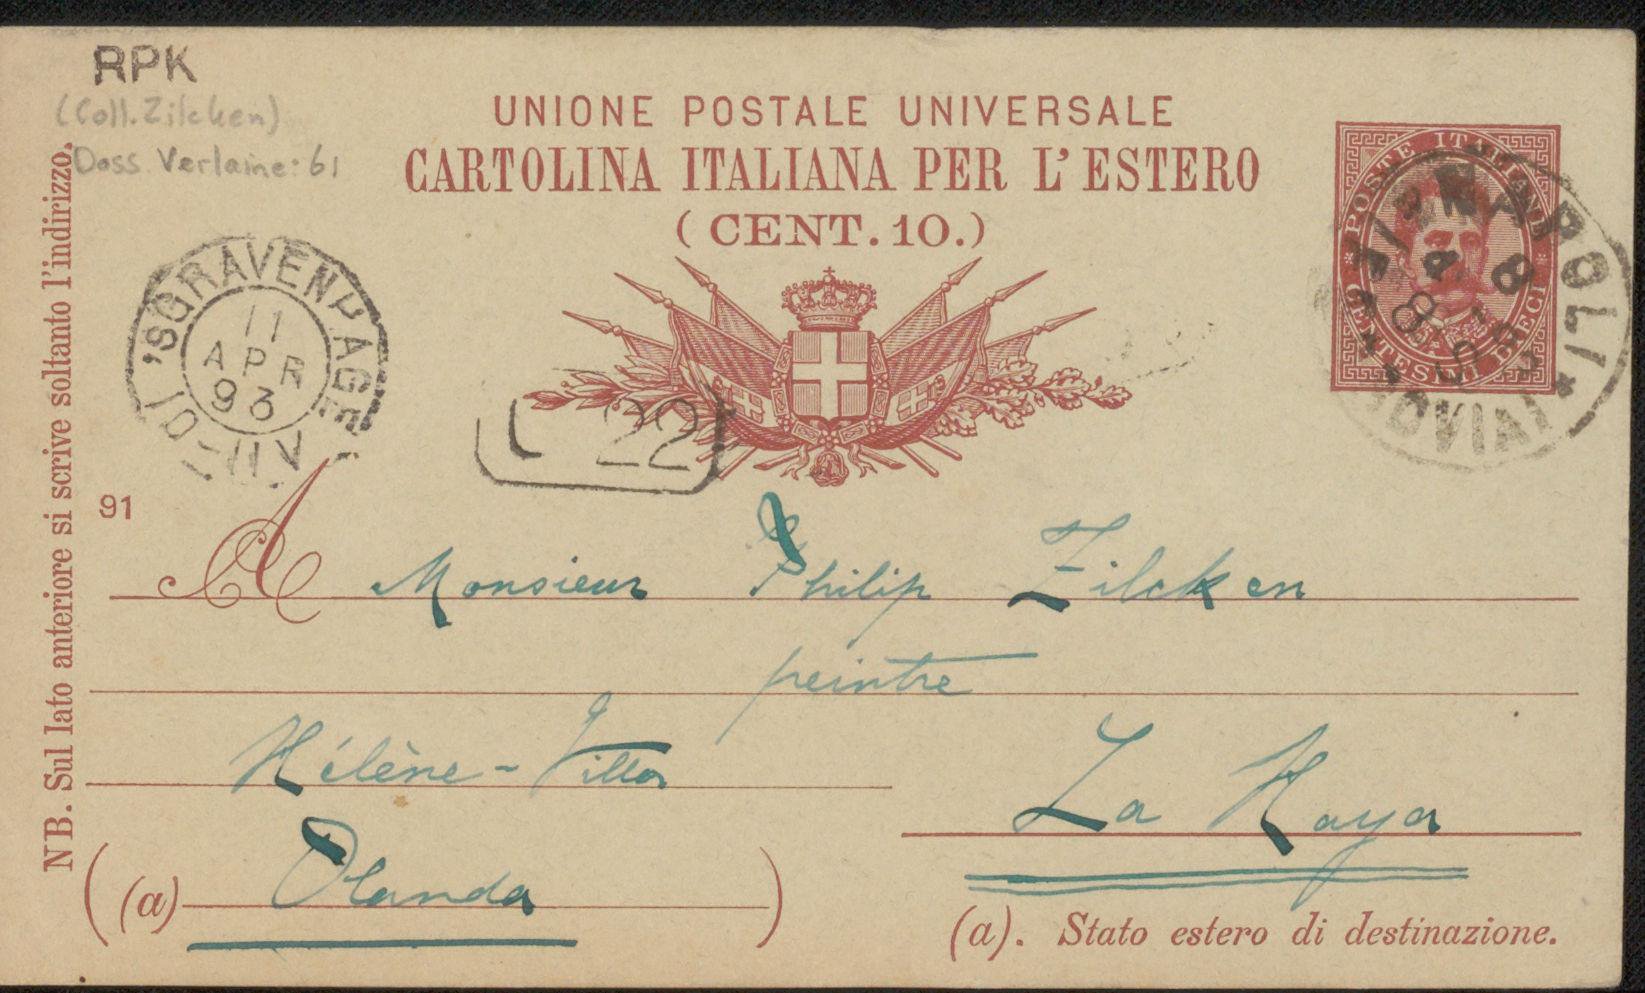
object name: postcard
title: Briefkaart aan Philip Zilcken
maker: vittorio pica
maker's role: criticus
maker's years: 1864-1930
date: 1893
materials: cardboard, ink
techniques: pen, writing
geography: naples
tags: paris, paul verlaine, painter, philip zilcken, historical persons (portraits and scenes from the life)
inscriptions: collector's mark: ‘RPK’